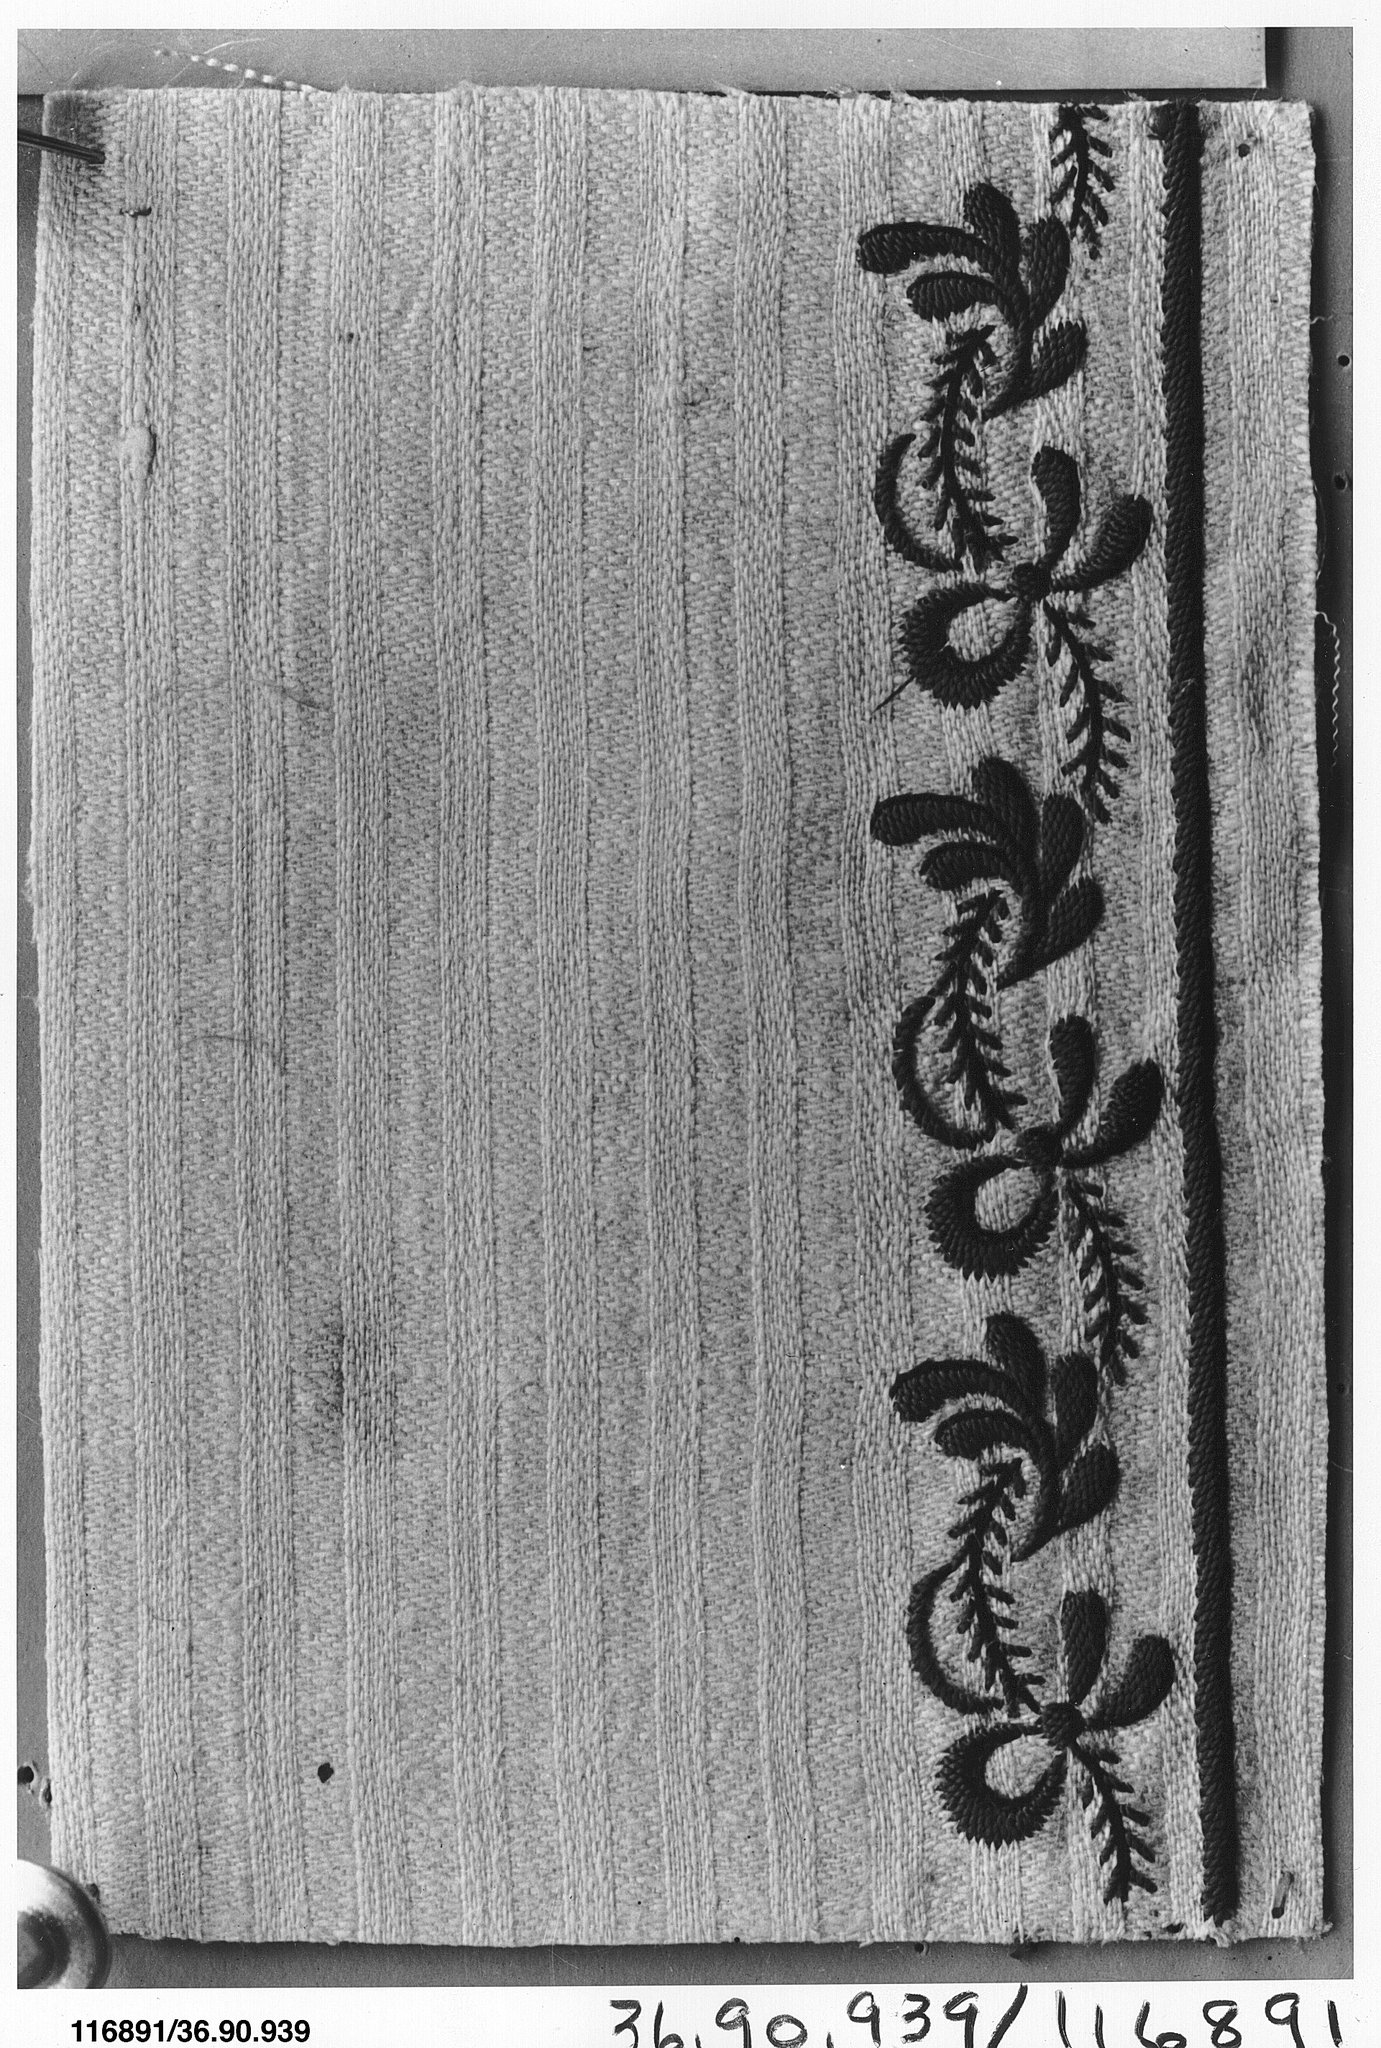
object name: sample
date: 1801-1833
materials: cotton, silk